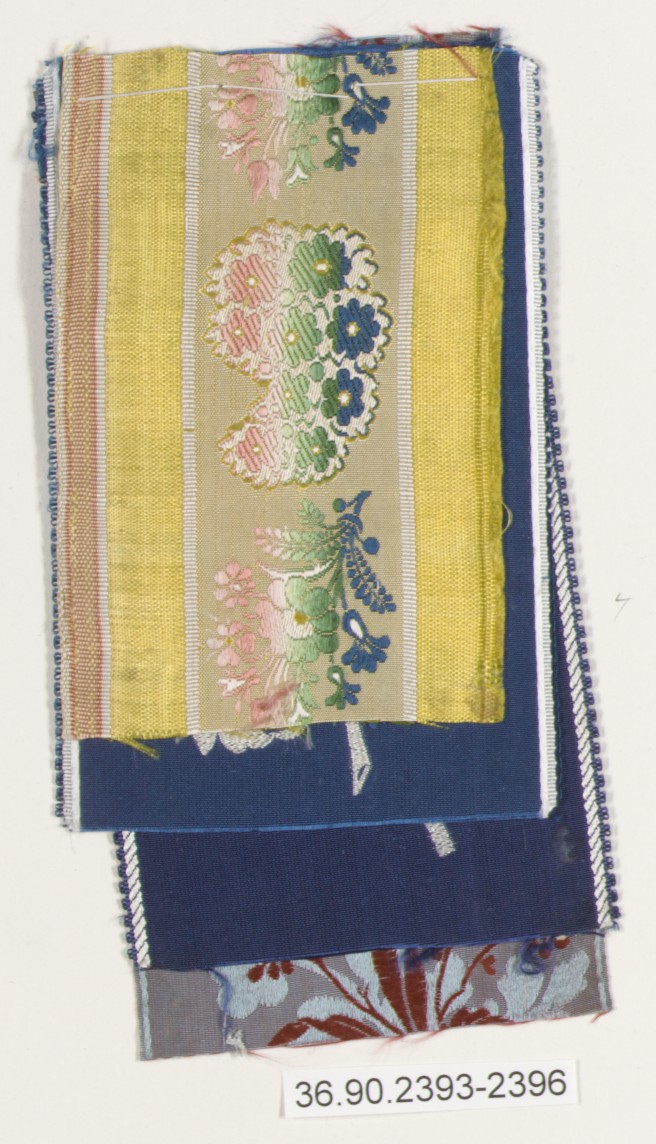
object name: ribbon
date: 1801-1900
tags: flowers